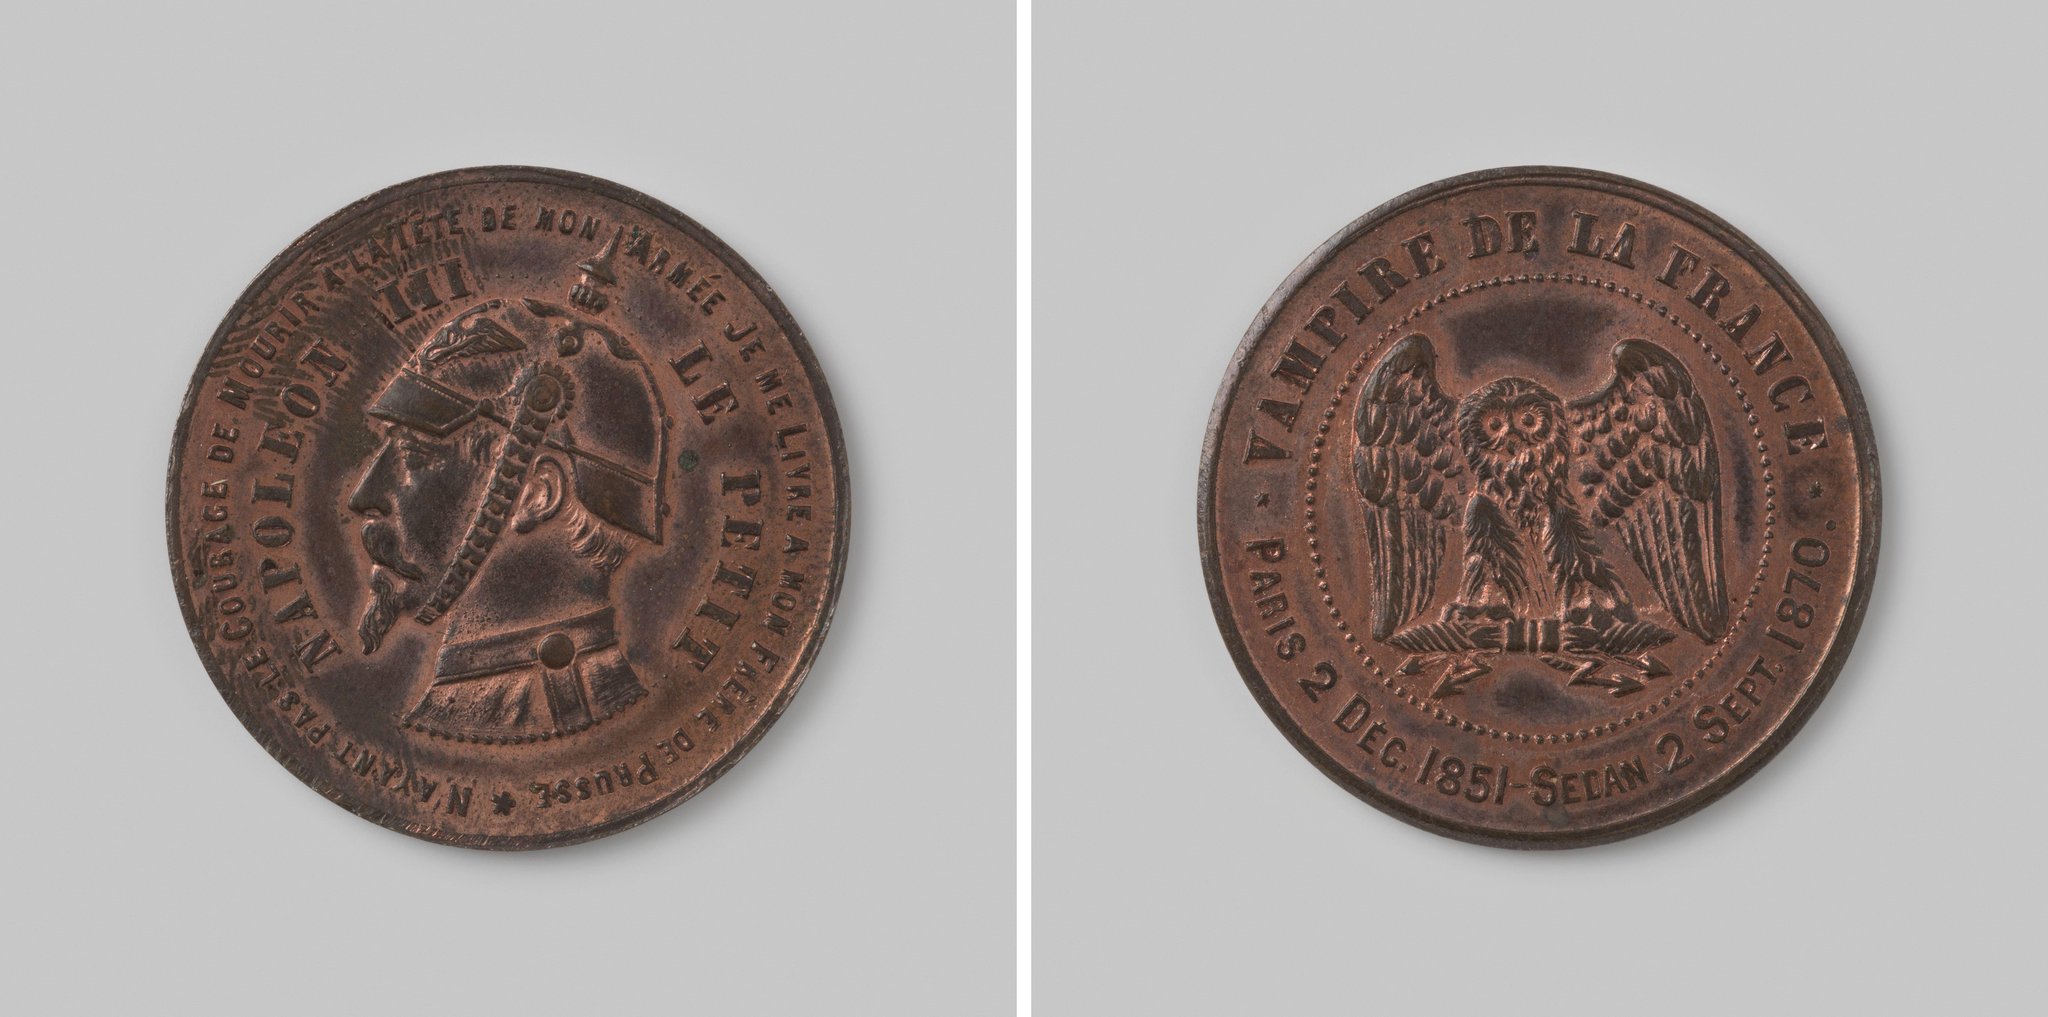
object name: history medal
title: Spotpenning op Keizer Napoleon III `Le Petit` 1870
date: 1870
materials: bronze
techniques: striking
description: Bronzen penning, op de voorzijde het borstbeeld van Keizer Napoleon III naar links met pickelhaube, met dubbel omschrift, op de keerzijde de Franse adelaar met vampierskop, met omschrift.